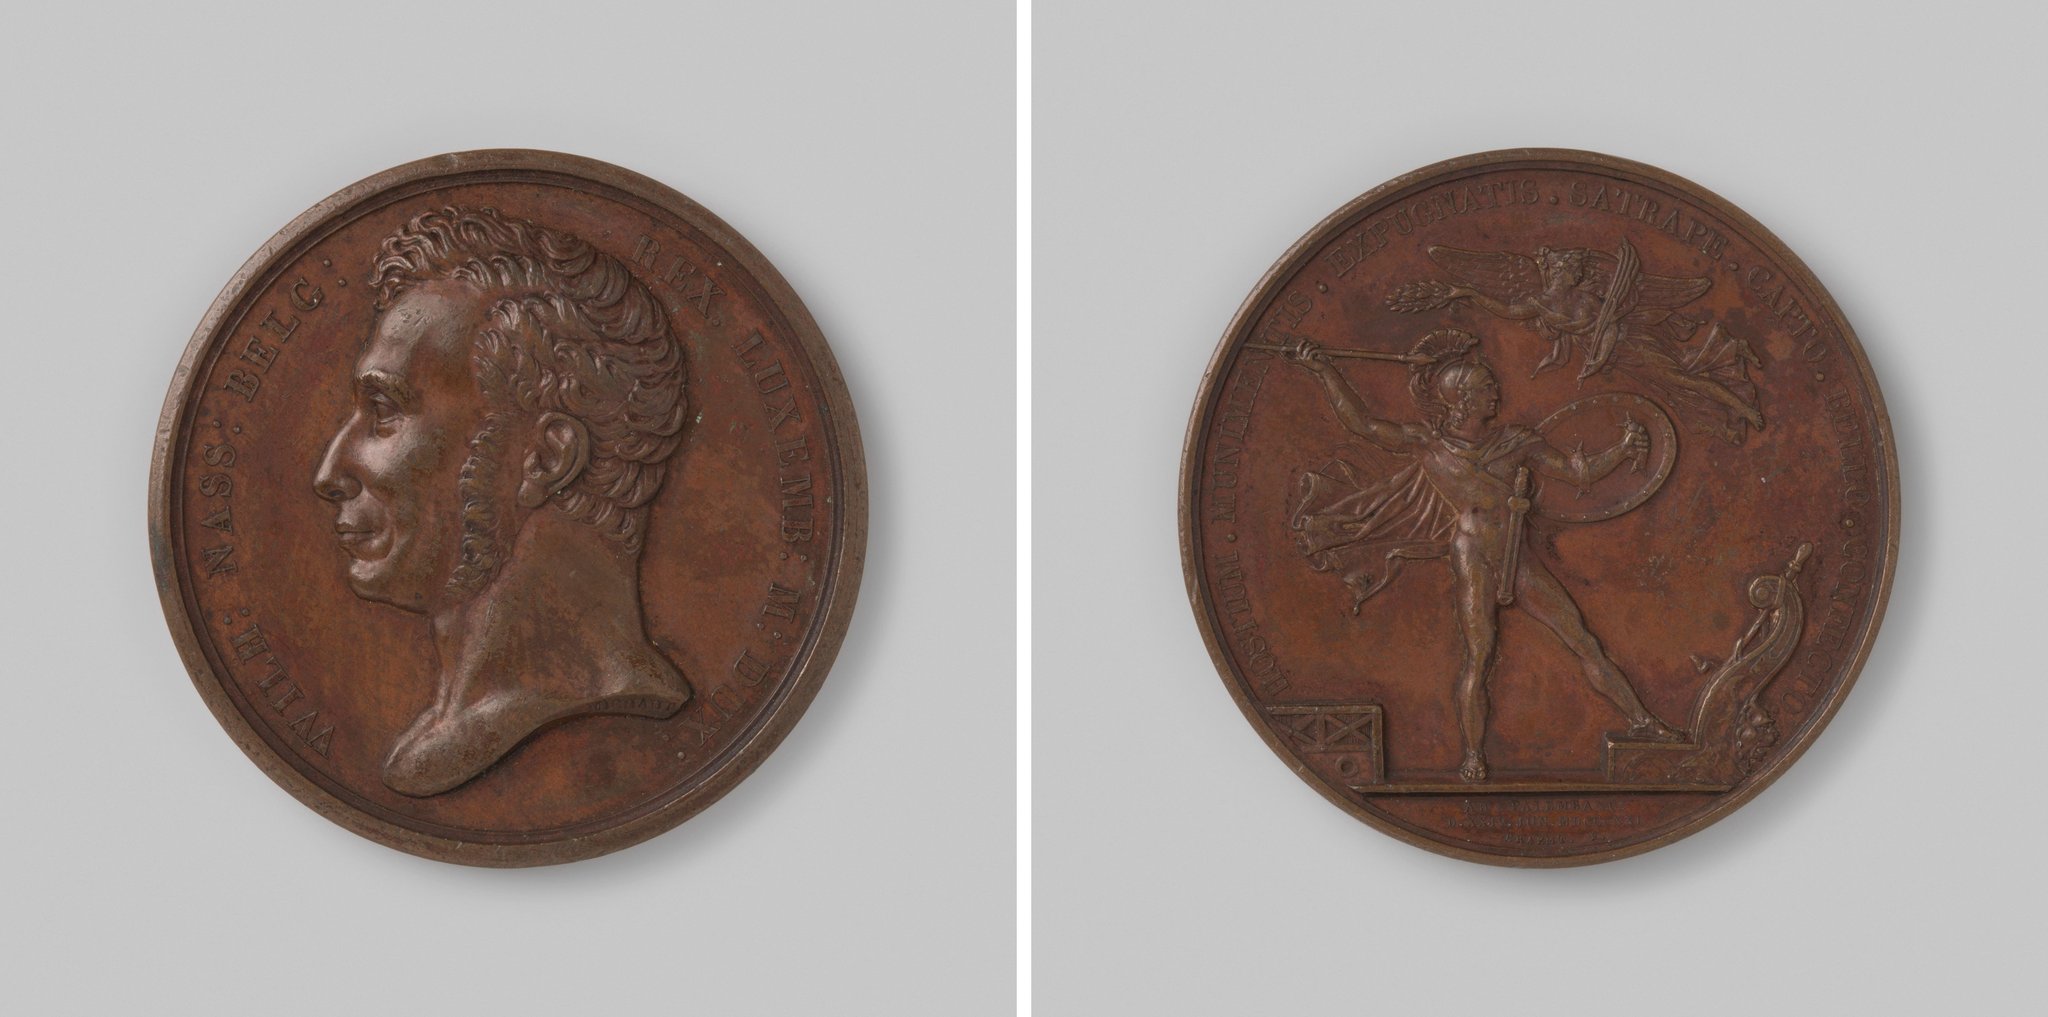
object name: history medal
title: Overwinning bij Palembang 1821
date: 1821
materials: bronze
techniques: striking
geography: brussels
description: Bronzen penning, op de voorzijde het portret van Koning Willem I naar links met omschrift, op de keerzijde een Romeins soldaat, één voet op een scheepsboeg, gelauwerd door een engel, met omschrift en afsnedetekst.